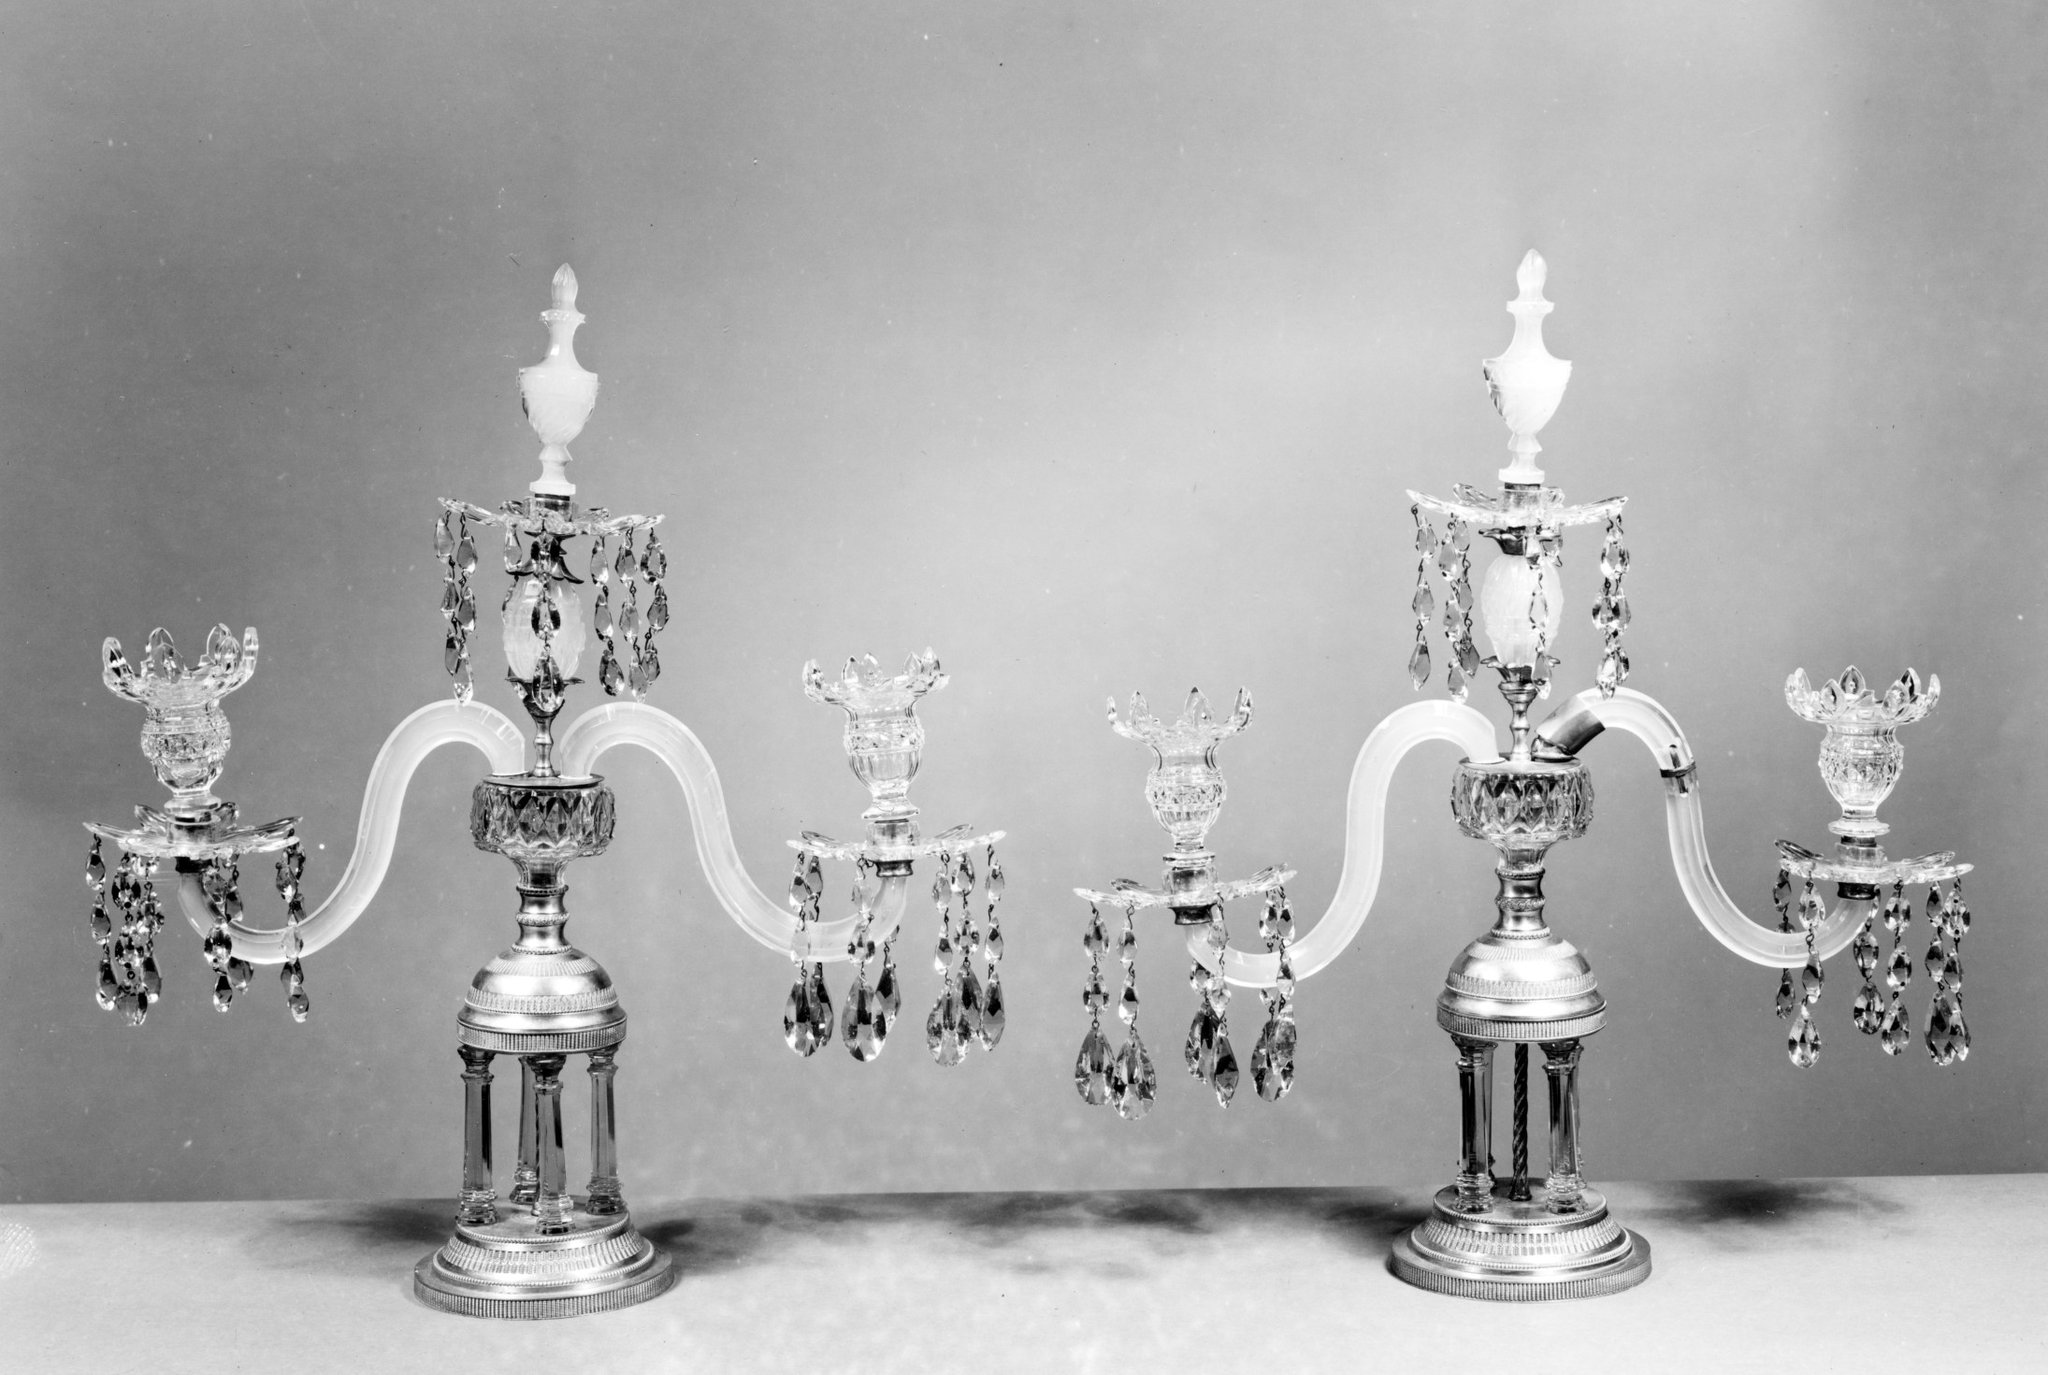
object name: candelabrum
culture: british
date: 1801-1900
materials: brass, glass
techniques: glassblowing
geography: england